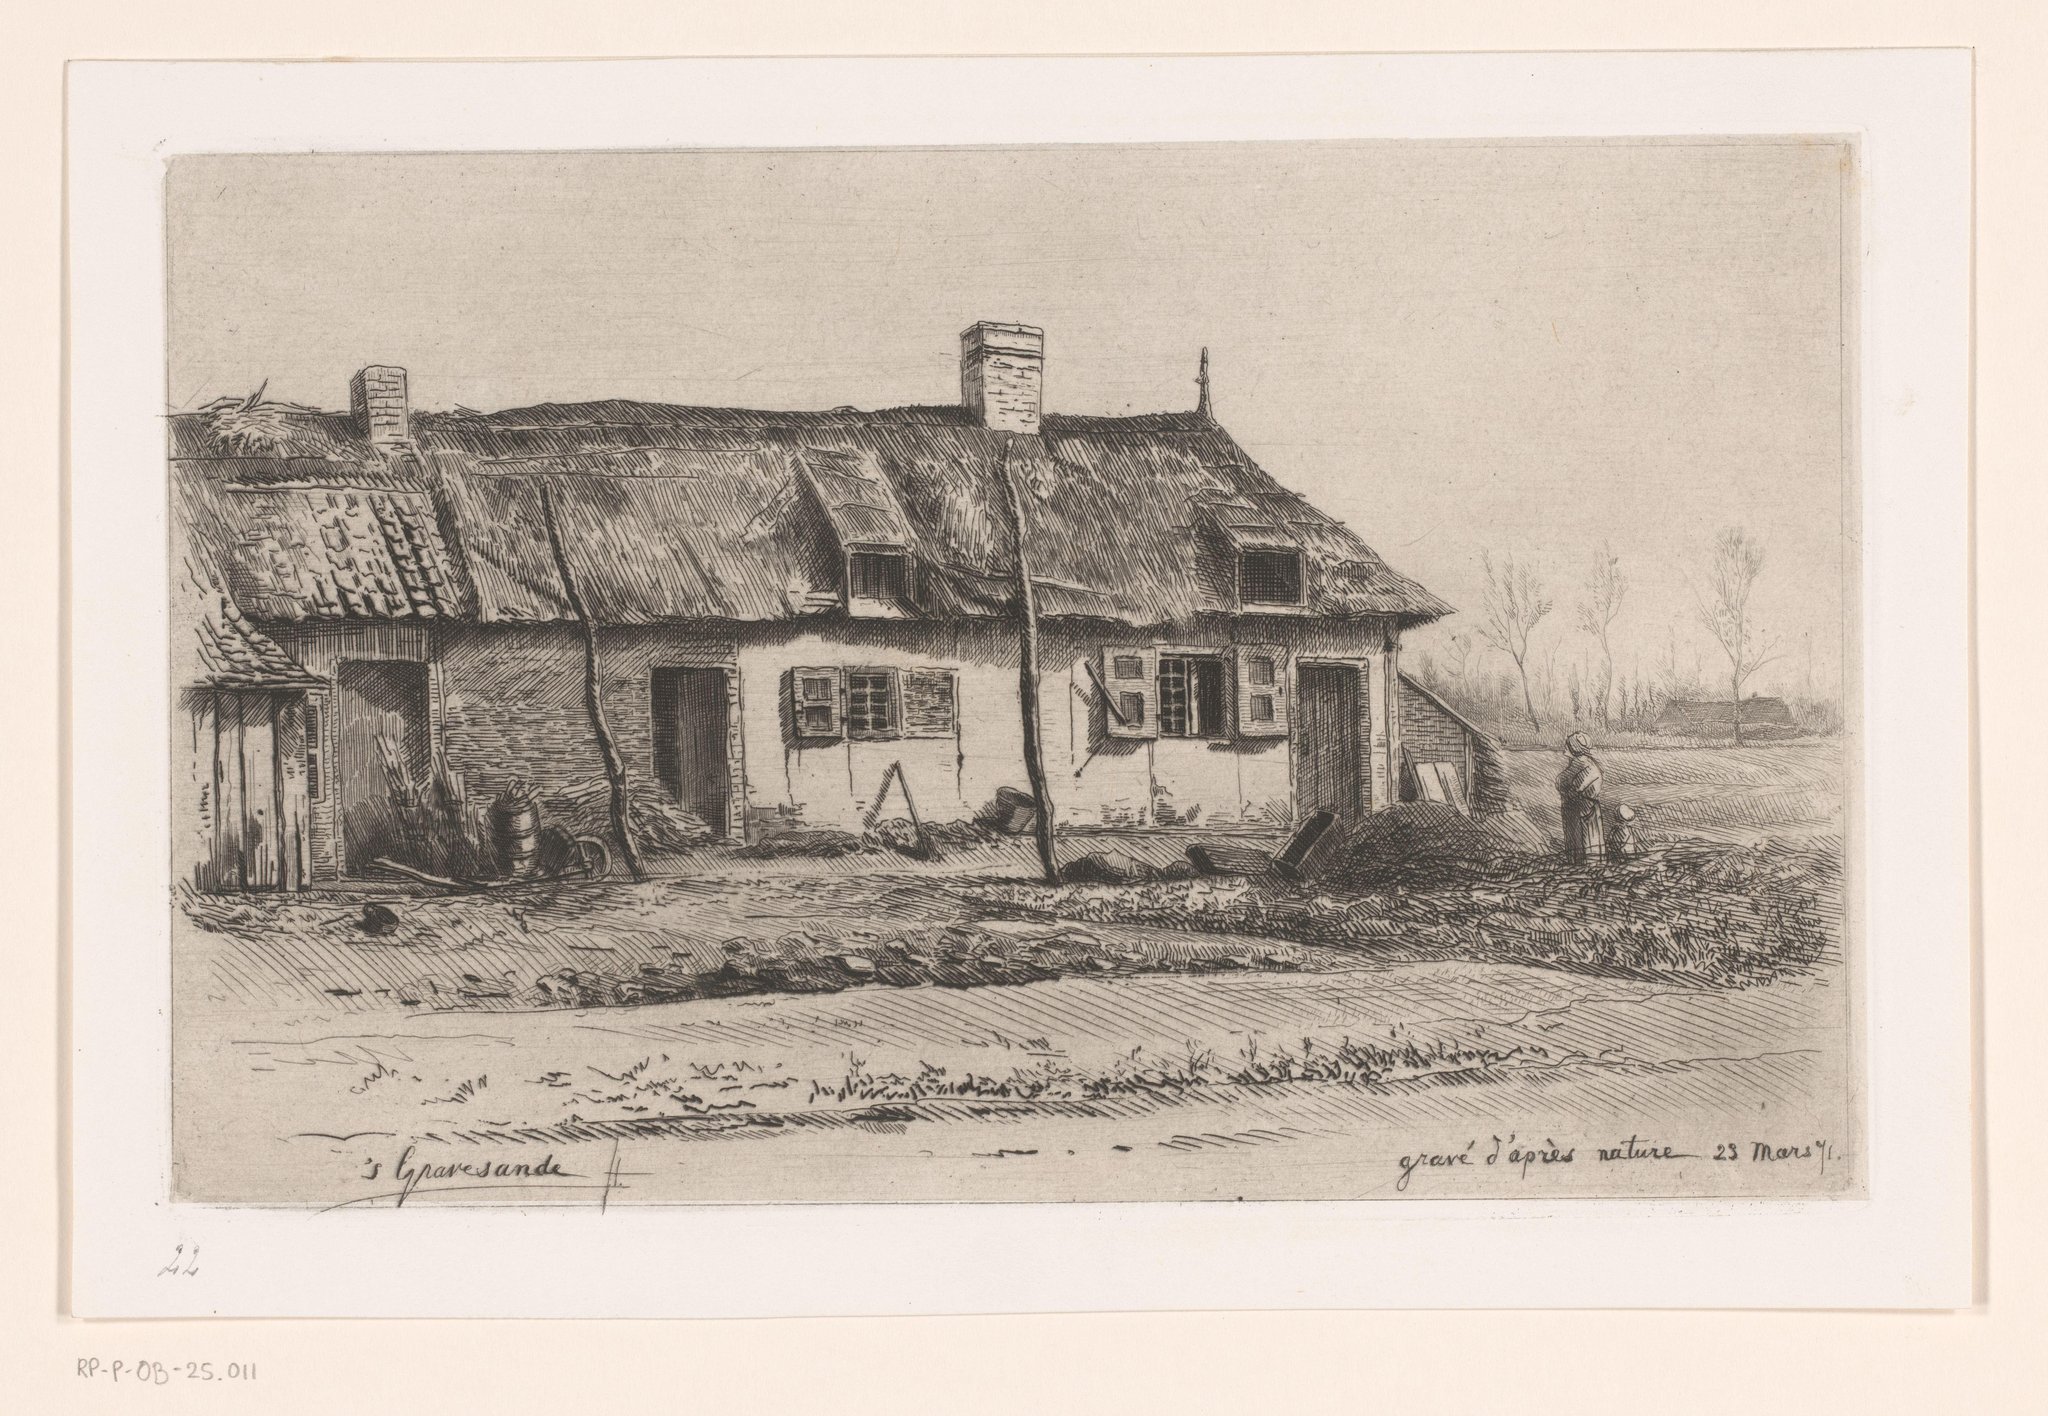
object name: print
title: Chaumière à Buggenhaut (Flandre orientale)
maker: carel nicolaas storm van s-gravesande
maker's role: draughtsman, print maker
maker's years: 1841-1924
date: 1871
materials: paper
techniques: etching, intaglio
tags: farm (building)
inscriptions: collector's mark: Lugt 2228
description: Boerderij met rieten dak. Rechts staan een vrouw en een kind op het erf.